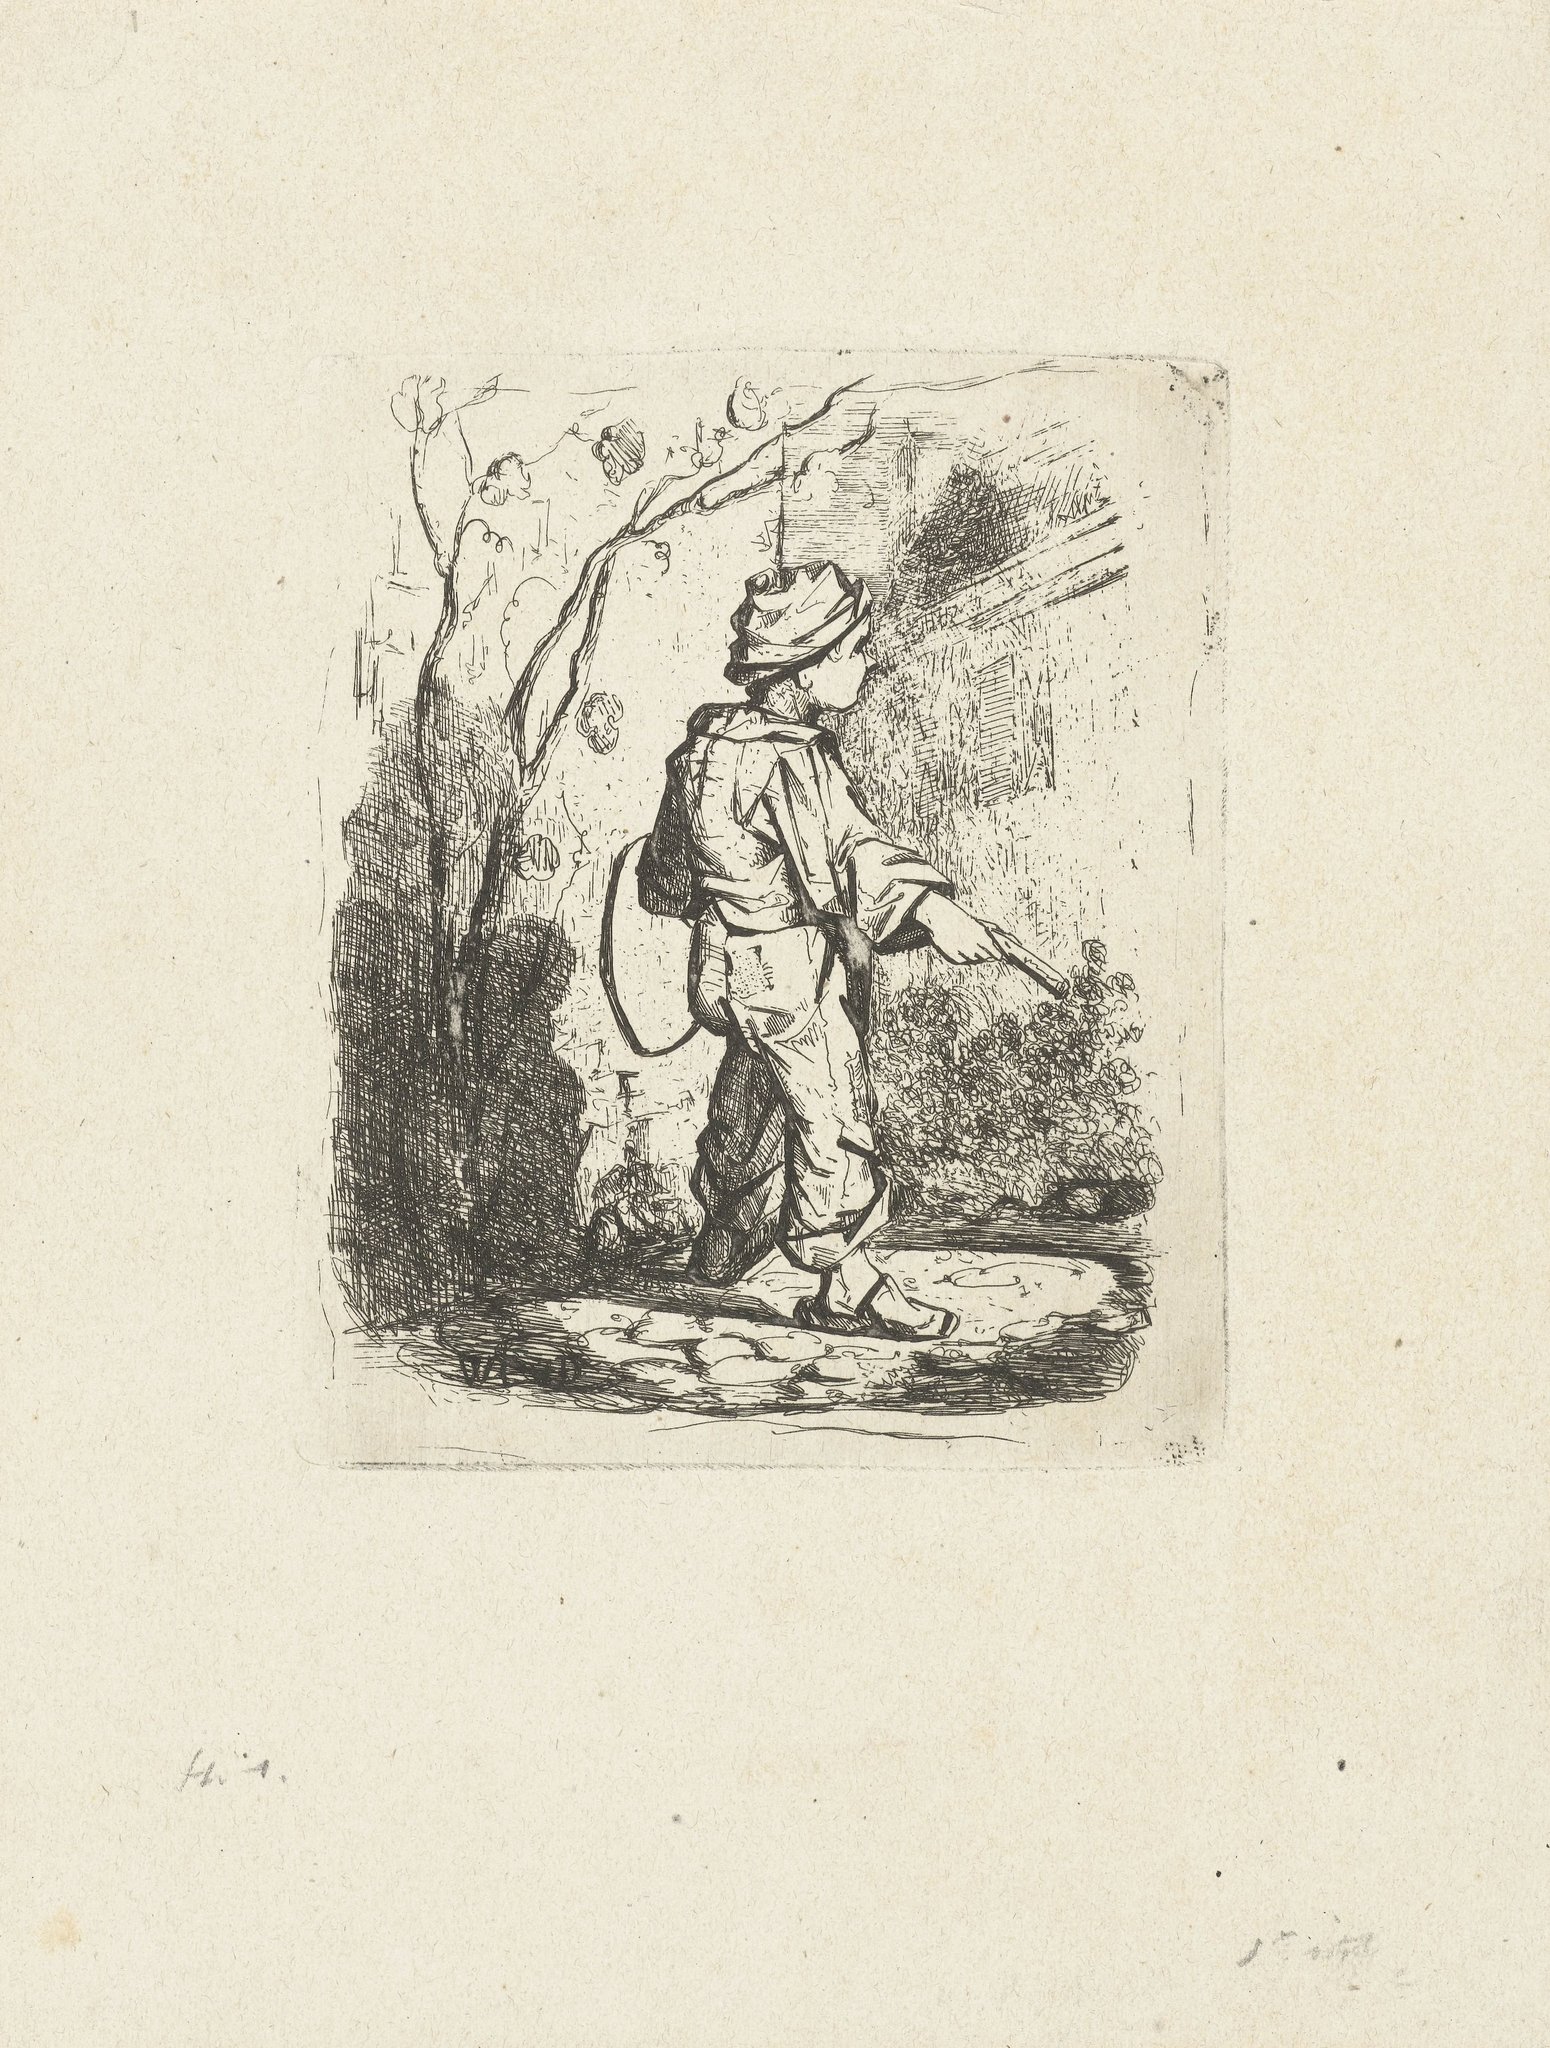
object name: print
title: Jongetje met hoepel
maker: willem cornelis van dijk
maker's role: painter, print maker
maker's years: 1826-1881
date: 1856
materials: paper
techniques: etching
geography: utrecht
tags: (bowling a) hoop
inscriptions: collector's mark: Lugt 2228